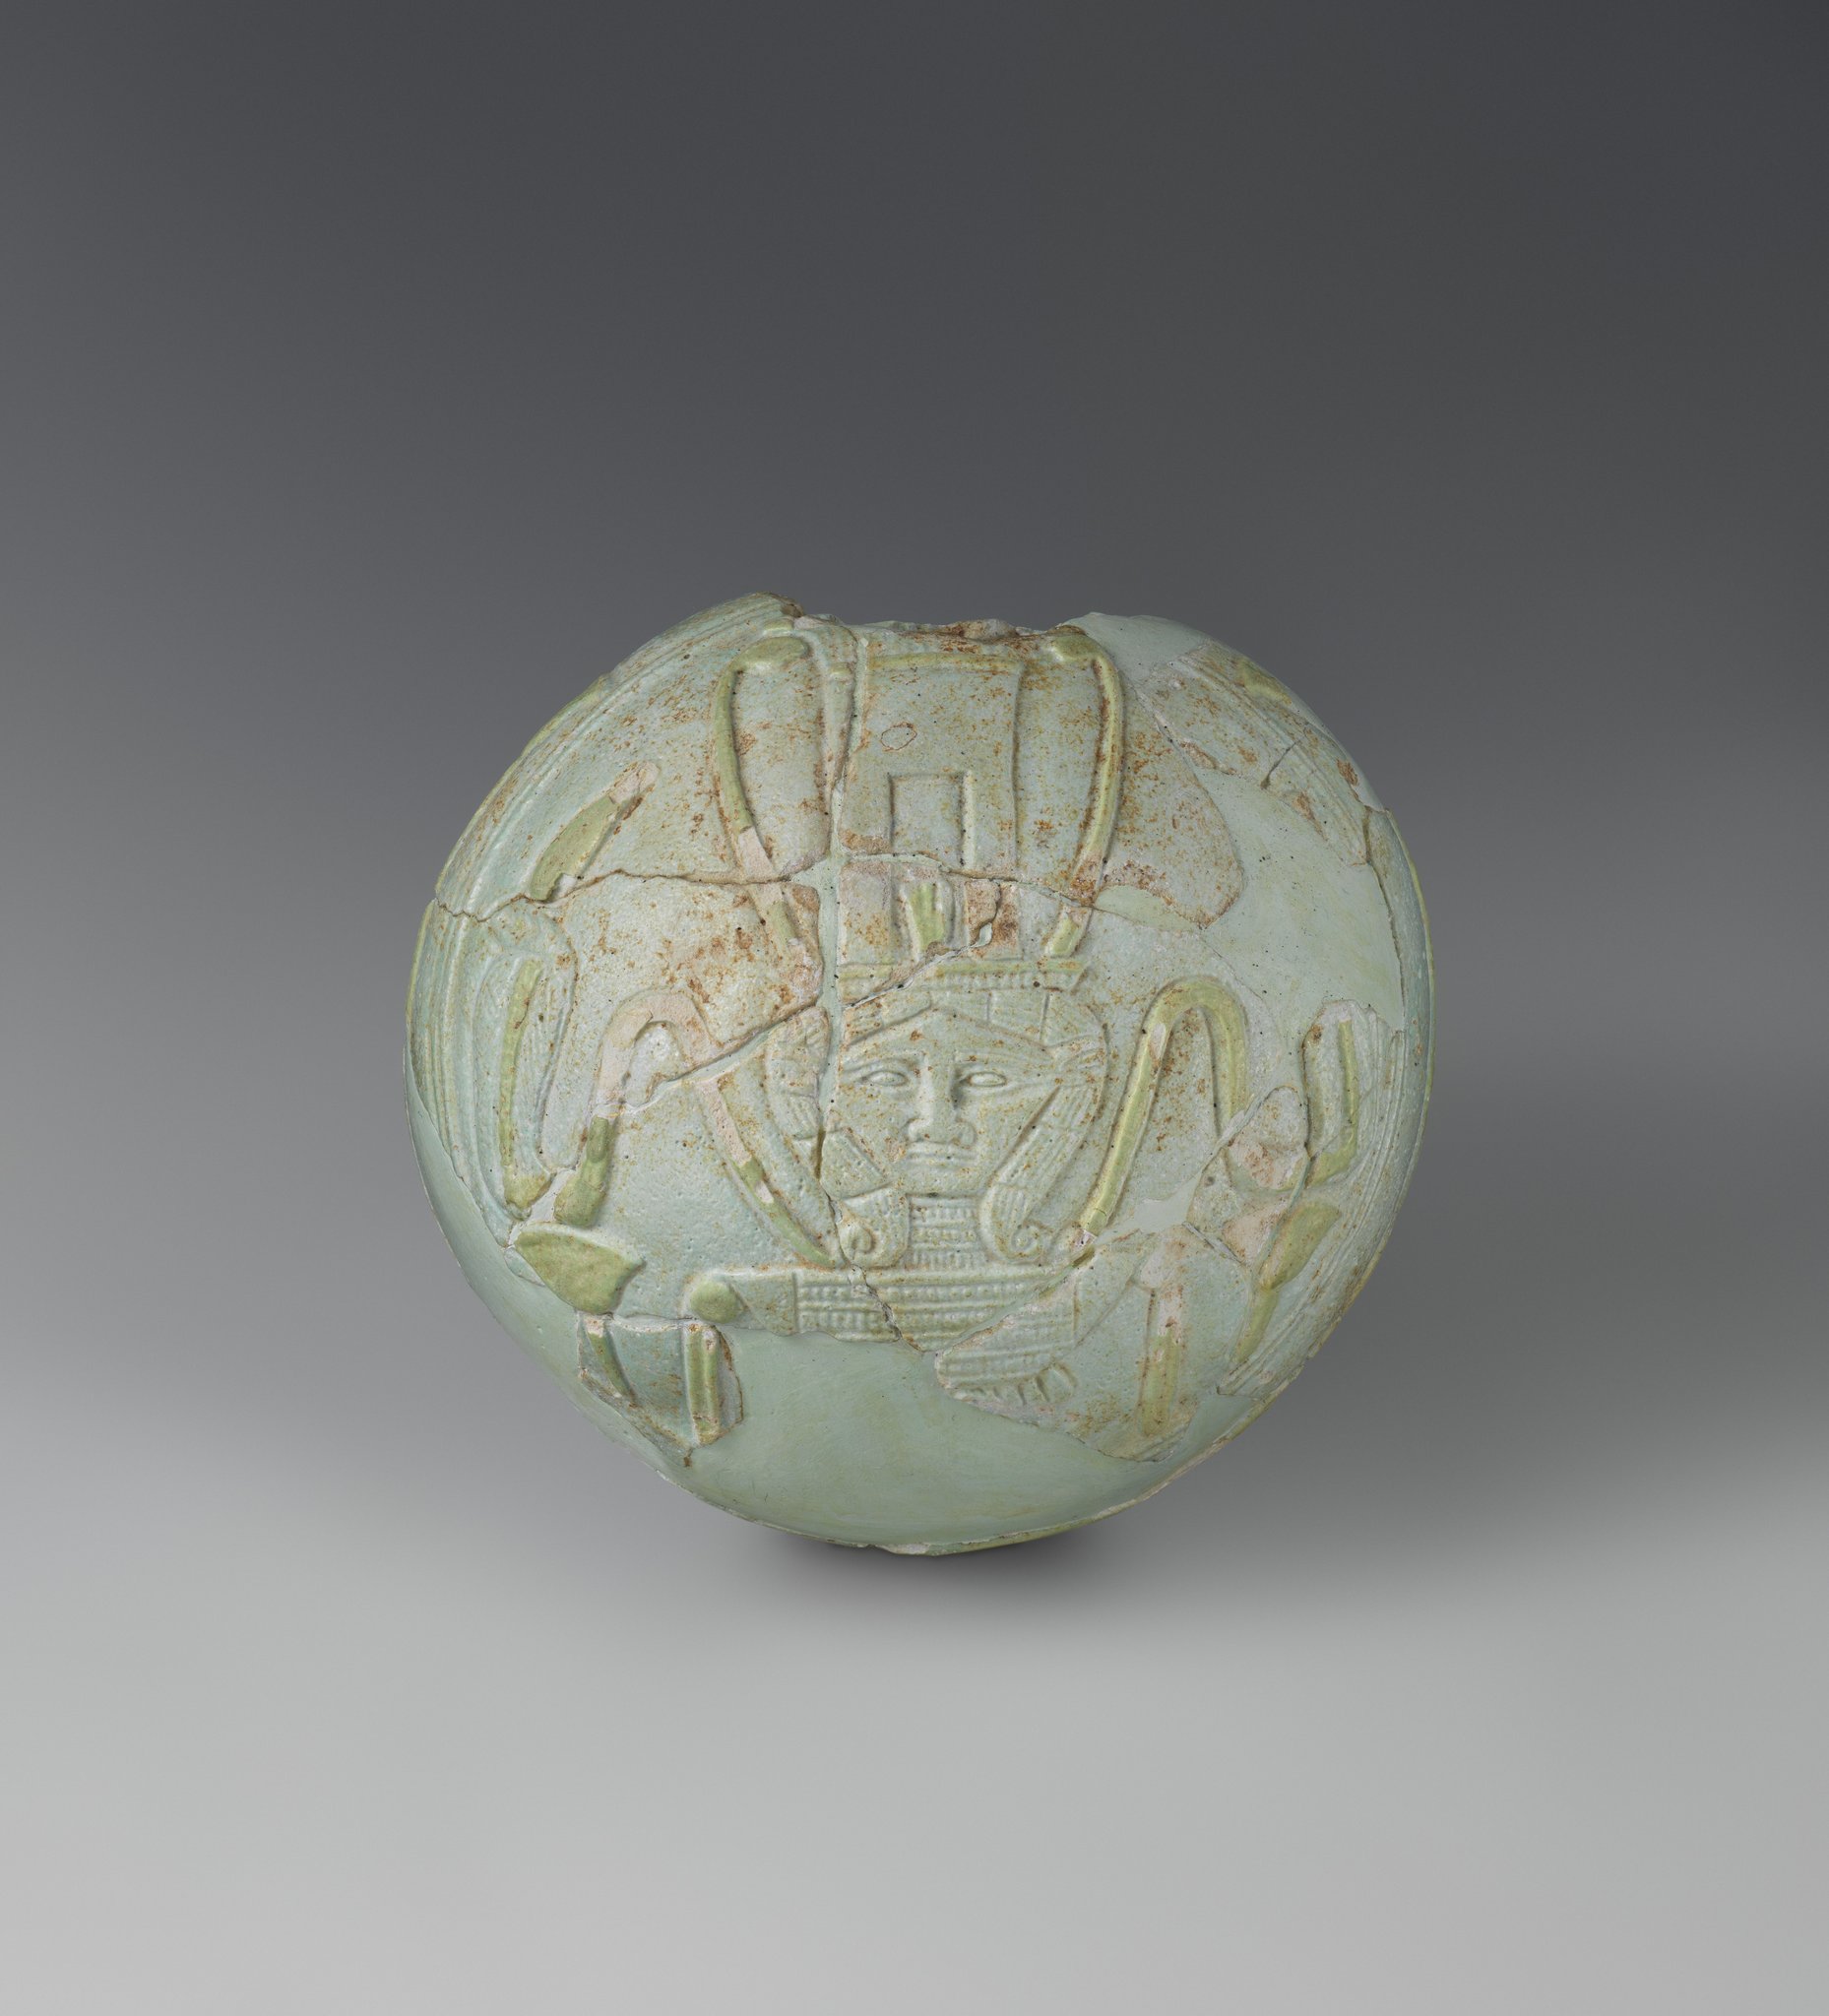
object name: lentoid bottle, new year's bottle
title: Lentoid Bottle ("New Year's Bottle"): Hathor sistrum on one side, cow in marshes on the opposite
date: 664-525 BCE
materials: faience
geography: egypt